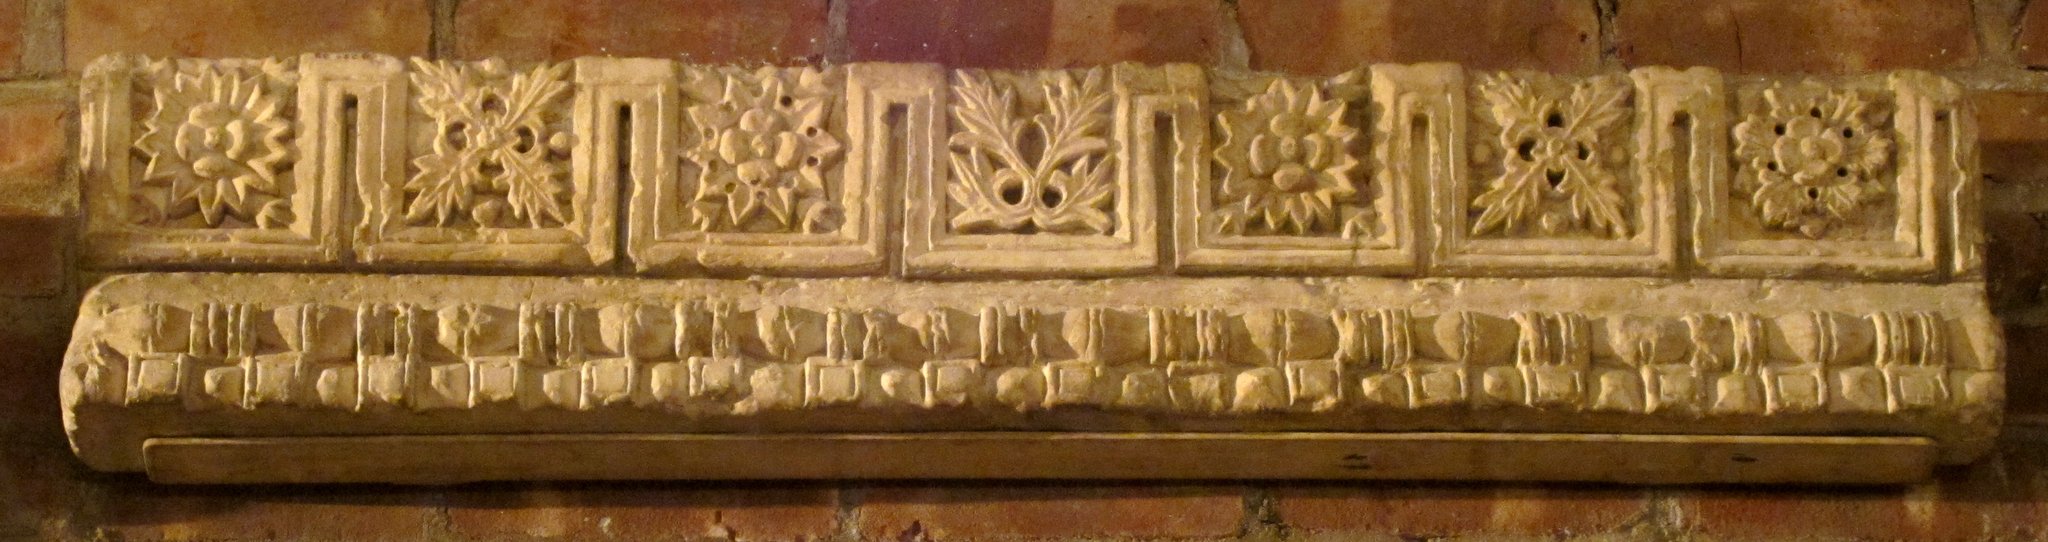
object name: fragment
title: Fragment from a Molding with Rosettes and Acanthus Clusters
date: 401-600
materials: limestone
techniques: carving, relief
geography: egypt